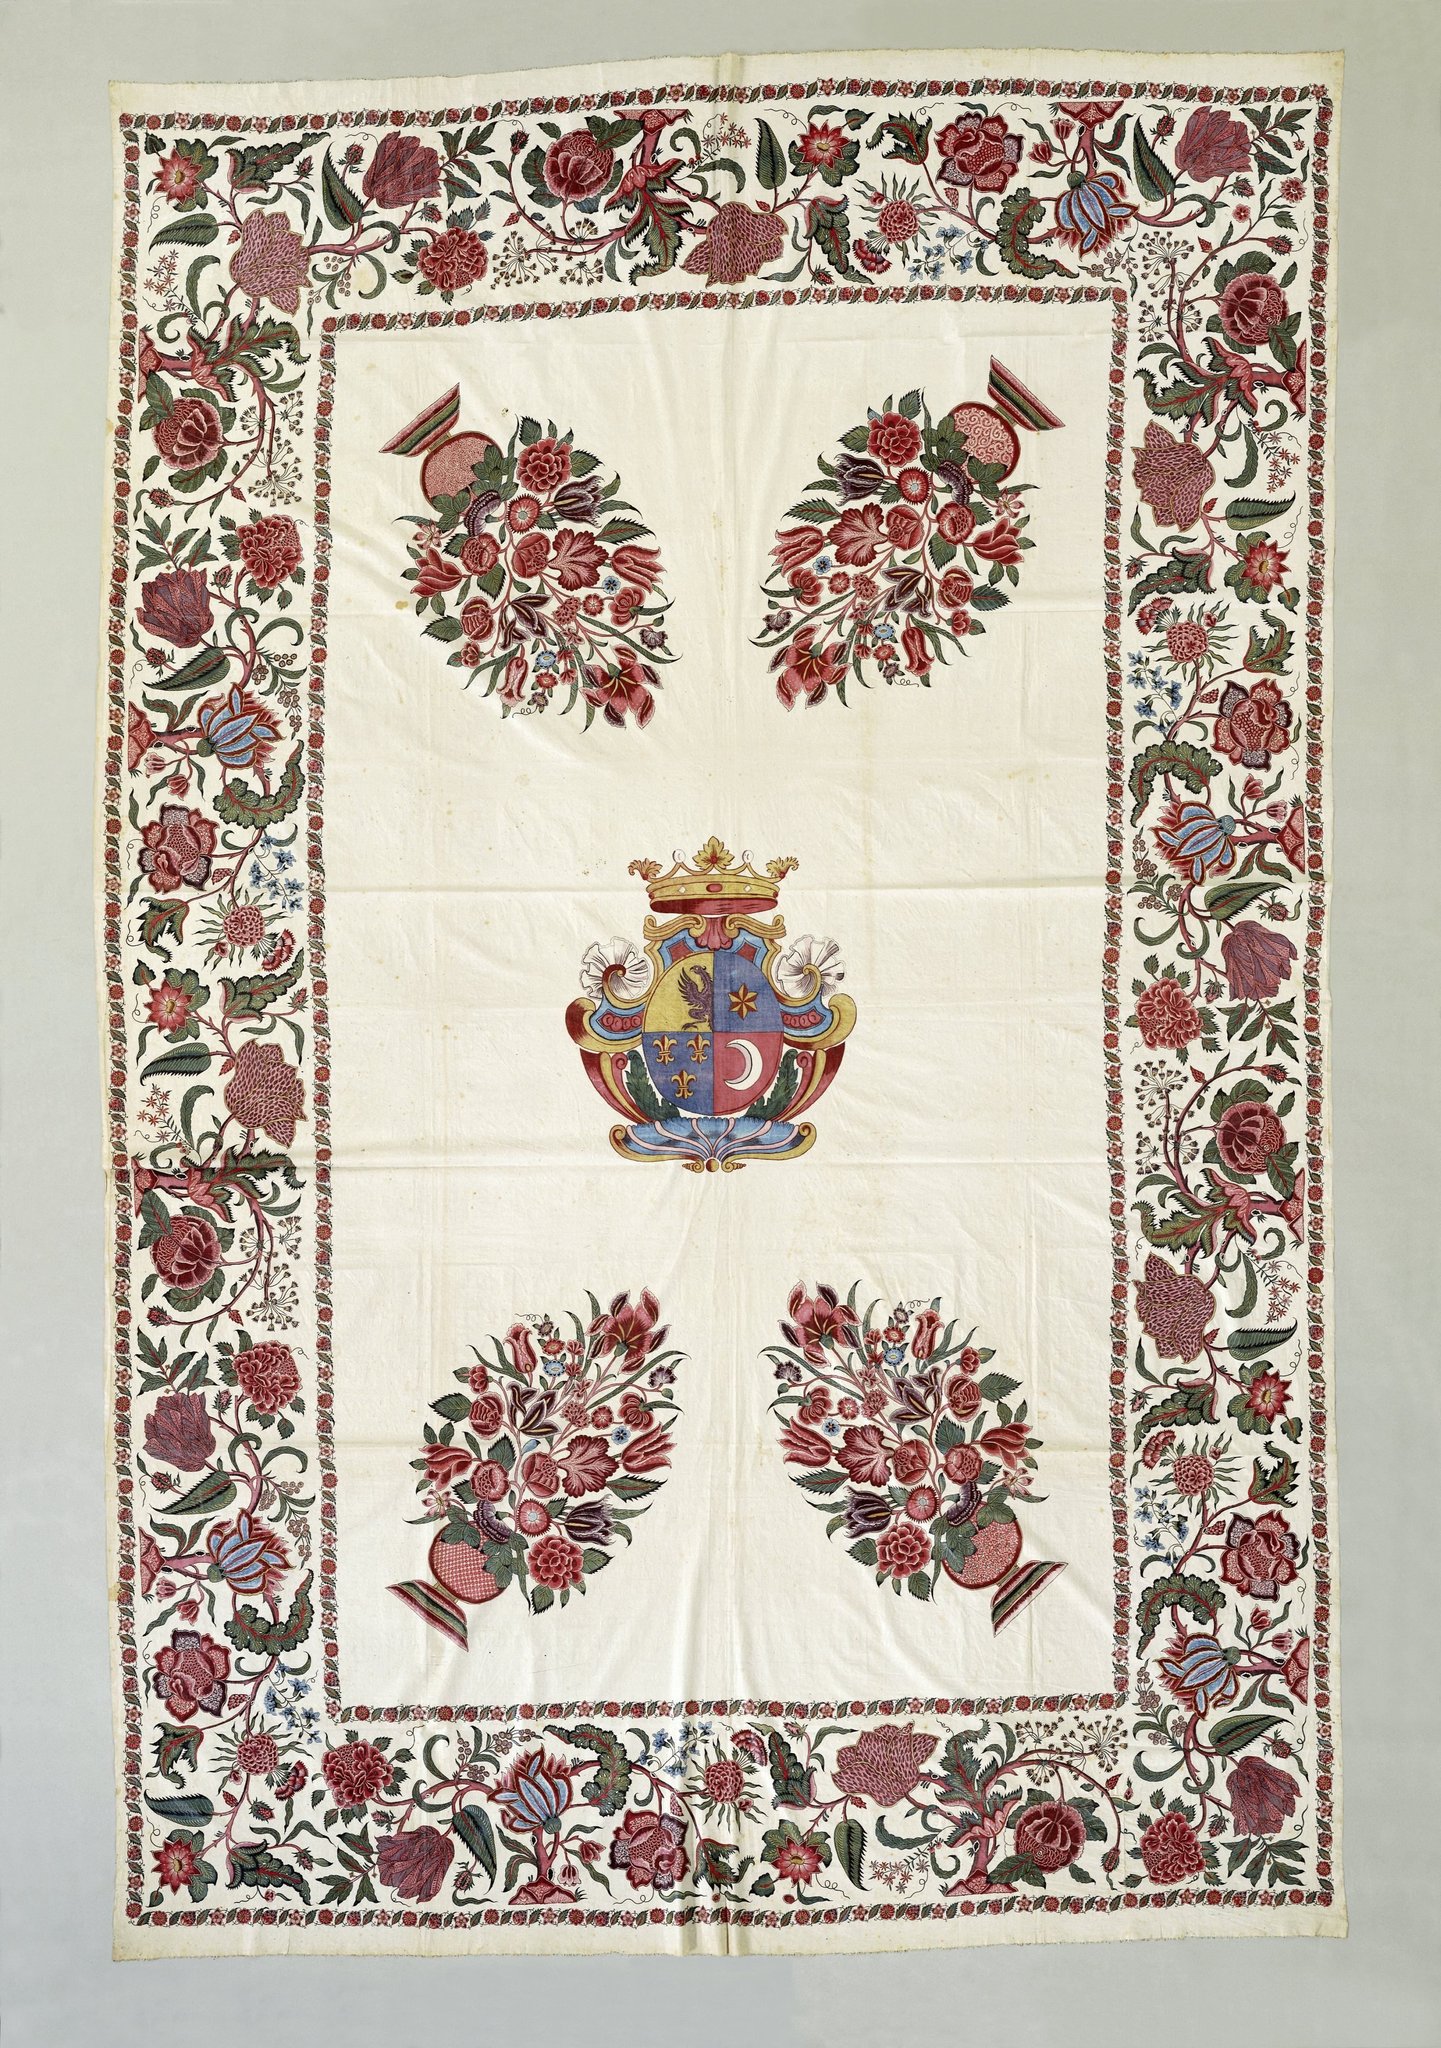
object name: textile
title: Sprei van katoenen sits met het wapen Goslinga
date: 1725-1750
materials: cotton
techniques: printing, weave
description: Ongevoerd veelkleurig sitsen wapensprei. In het middenveld centraal een ovaal schild met het wapen Goslinga; in de vier hoeken een bloemboeket in een pot op voet. In de randen gedrongen bomen met uitwaaierende takken, bloemen en bladeren. Oosters textiel.